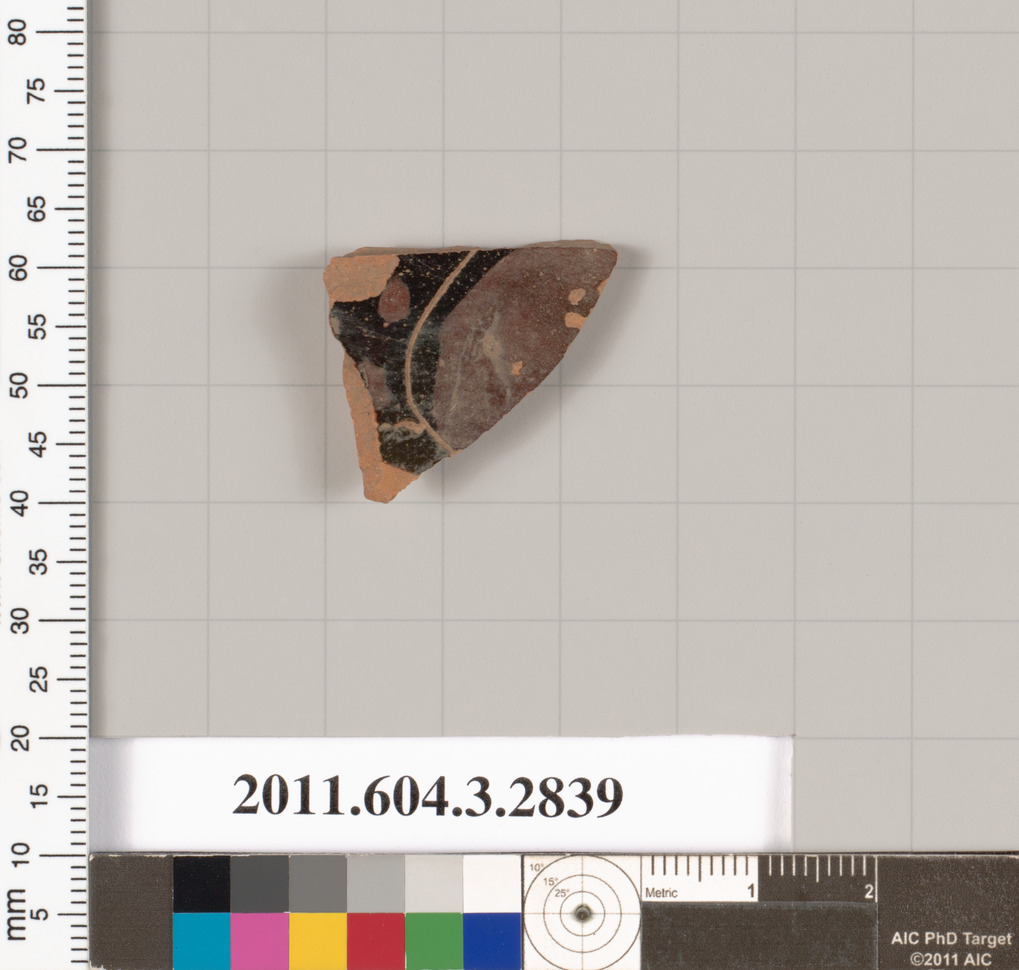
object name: undetermined closed shape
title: Terracotta fragment of a closed shape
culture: greek, attic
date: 534-468 BCE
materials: terracotta